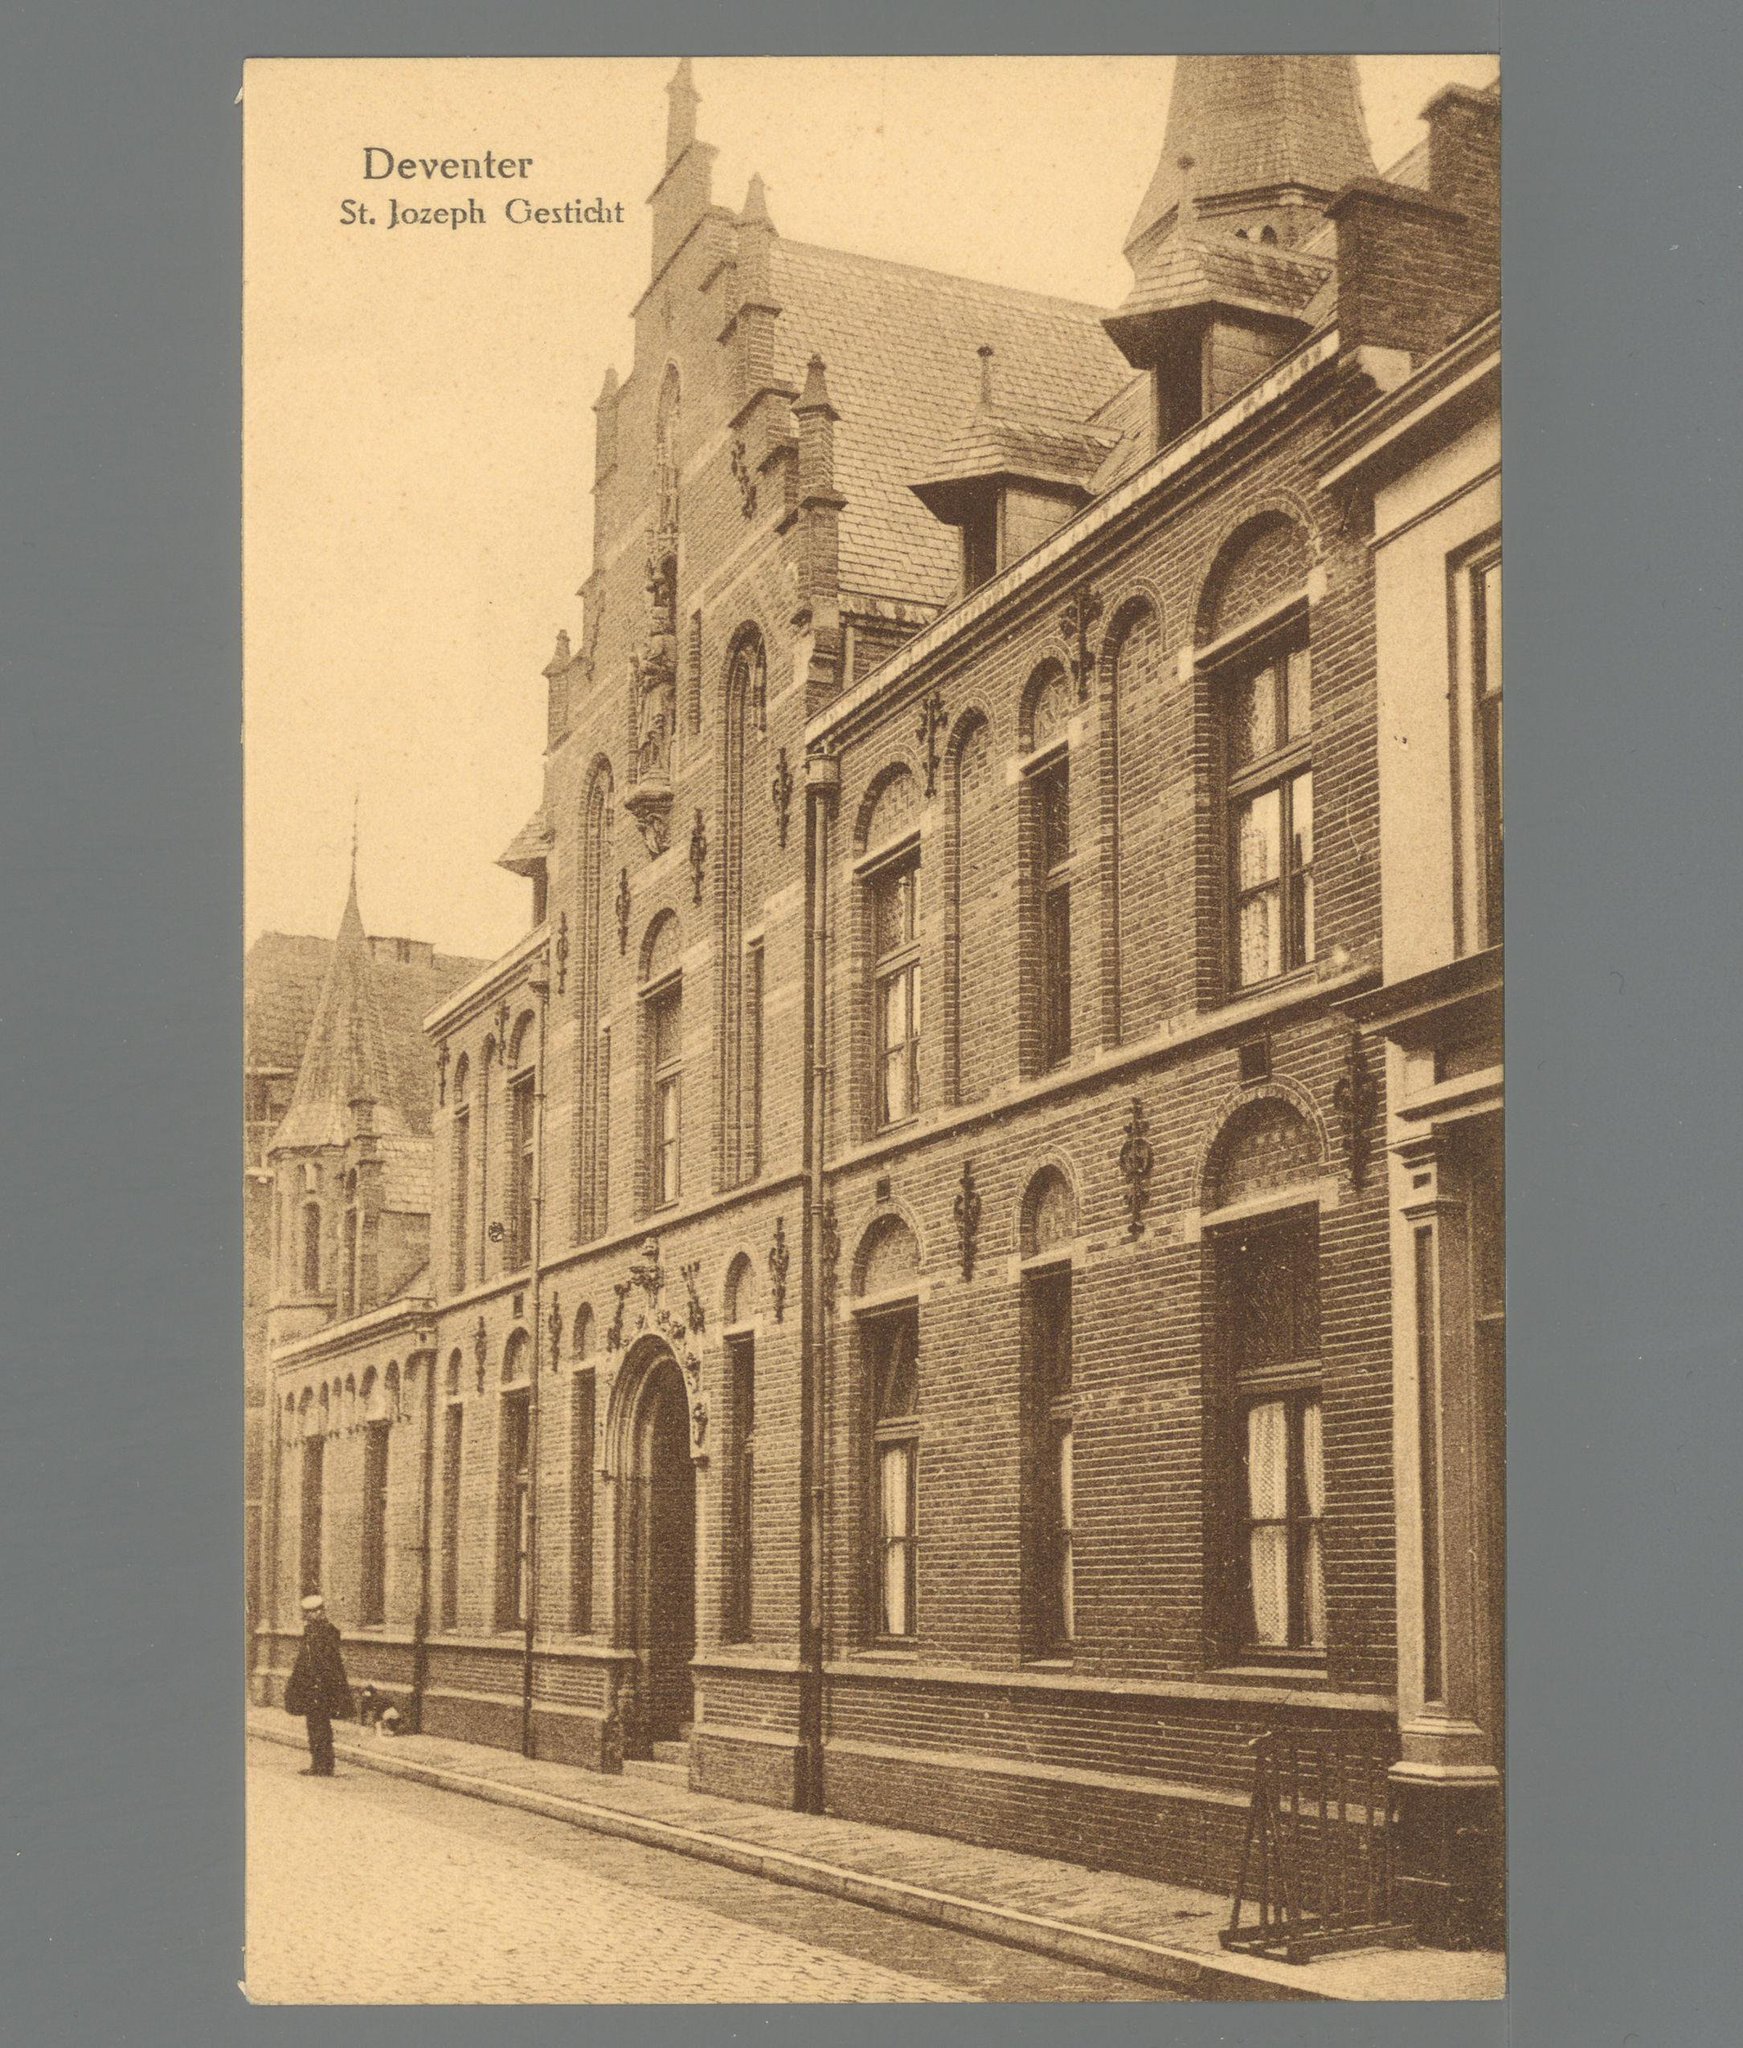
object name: ansichtkaart, prentbriefkaart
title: Deventer. St. Jozeph Gesticht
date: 1905-1930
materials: cardboard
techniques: photograph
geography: amersfoort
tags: façade (of house or building), lunatic asylum, mental home, deventer